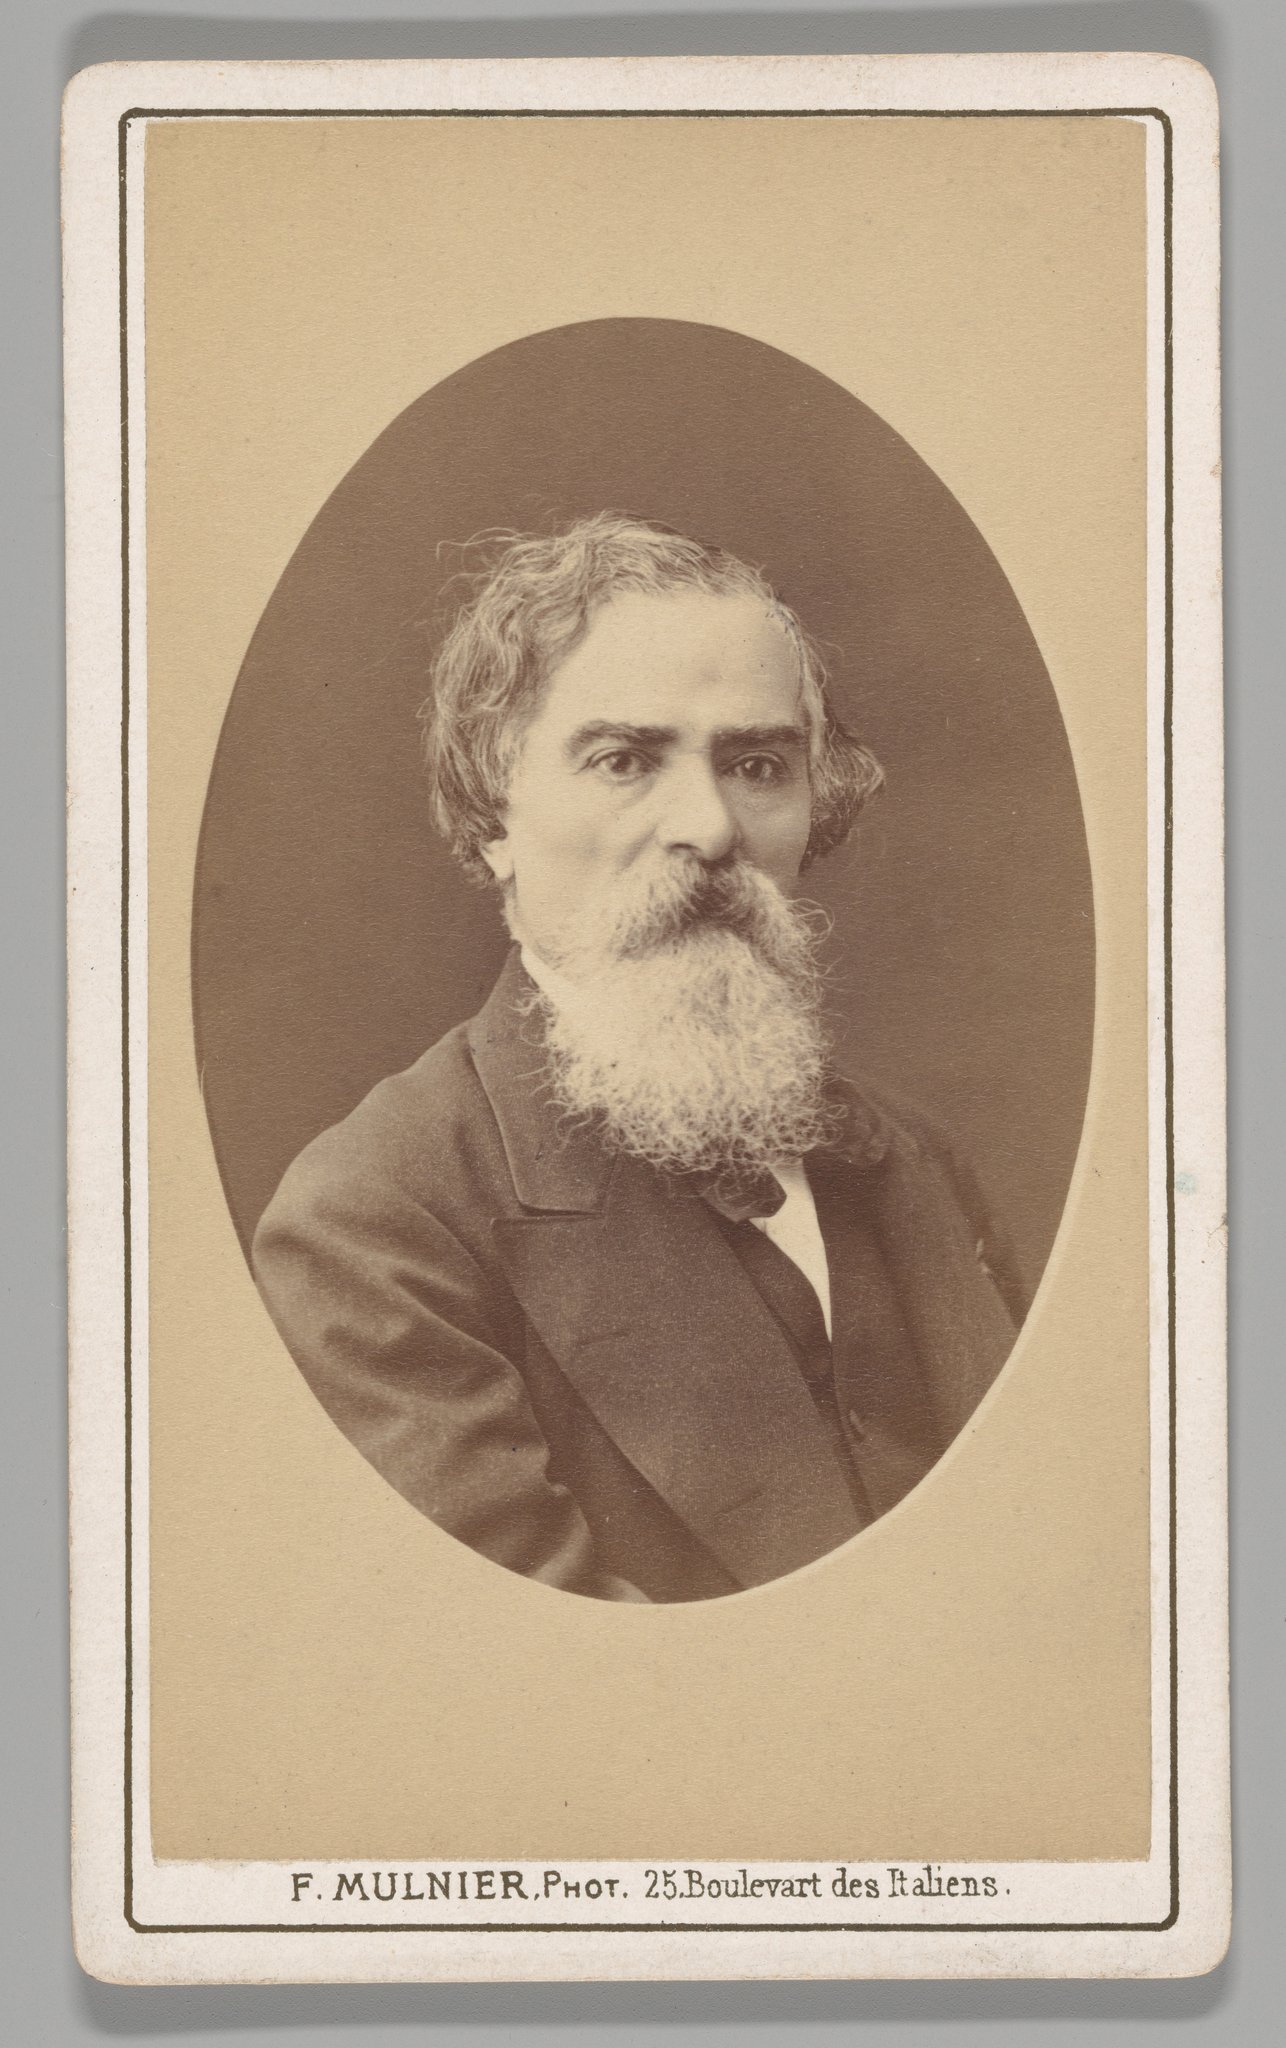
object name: carte de visite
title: [Virgilio Narcisso Diaz de la Pena]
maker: ferdinand mulnier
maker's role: artist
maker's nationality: french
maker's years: 1850-1875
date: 1857-1871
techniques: albumen silver print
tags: men,portraits